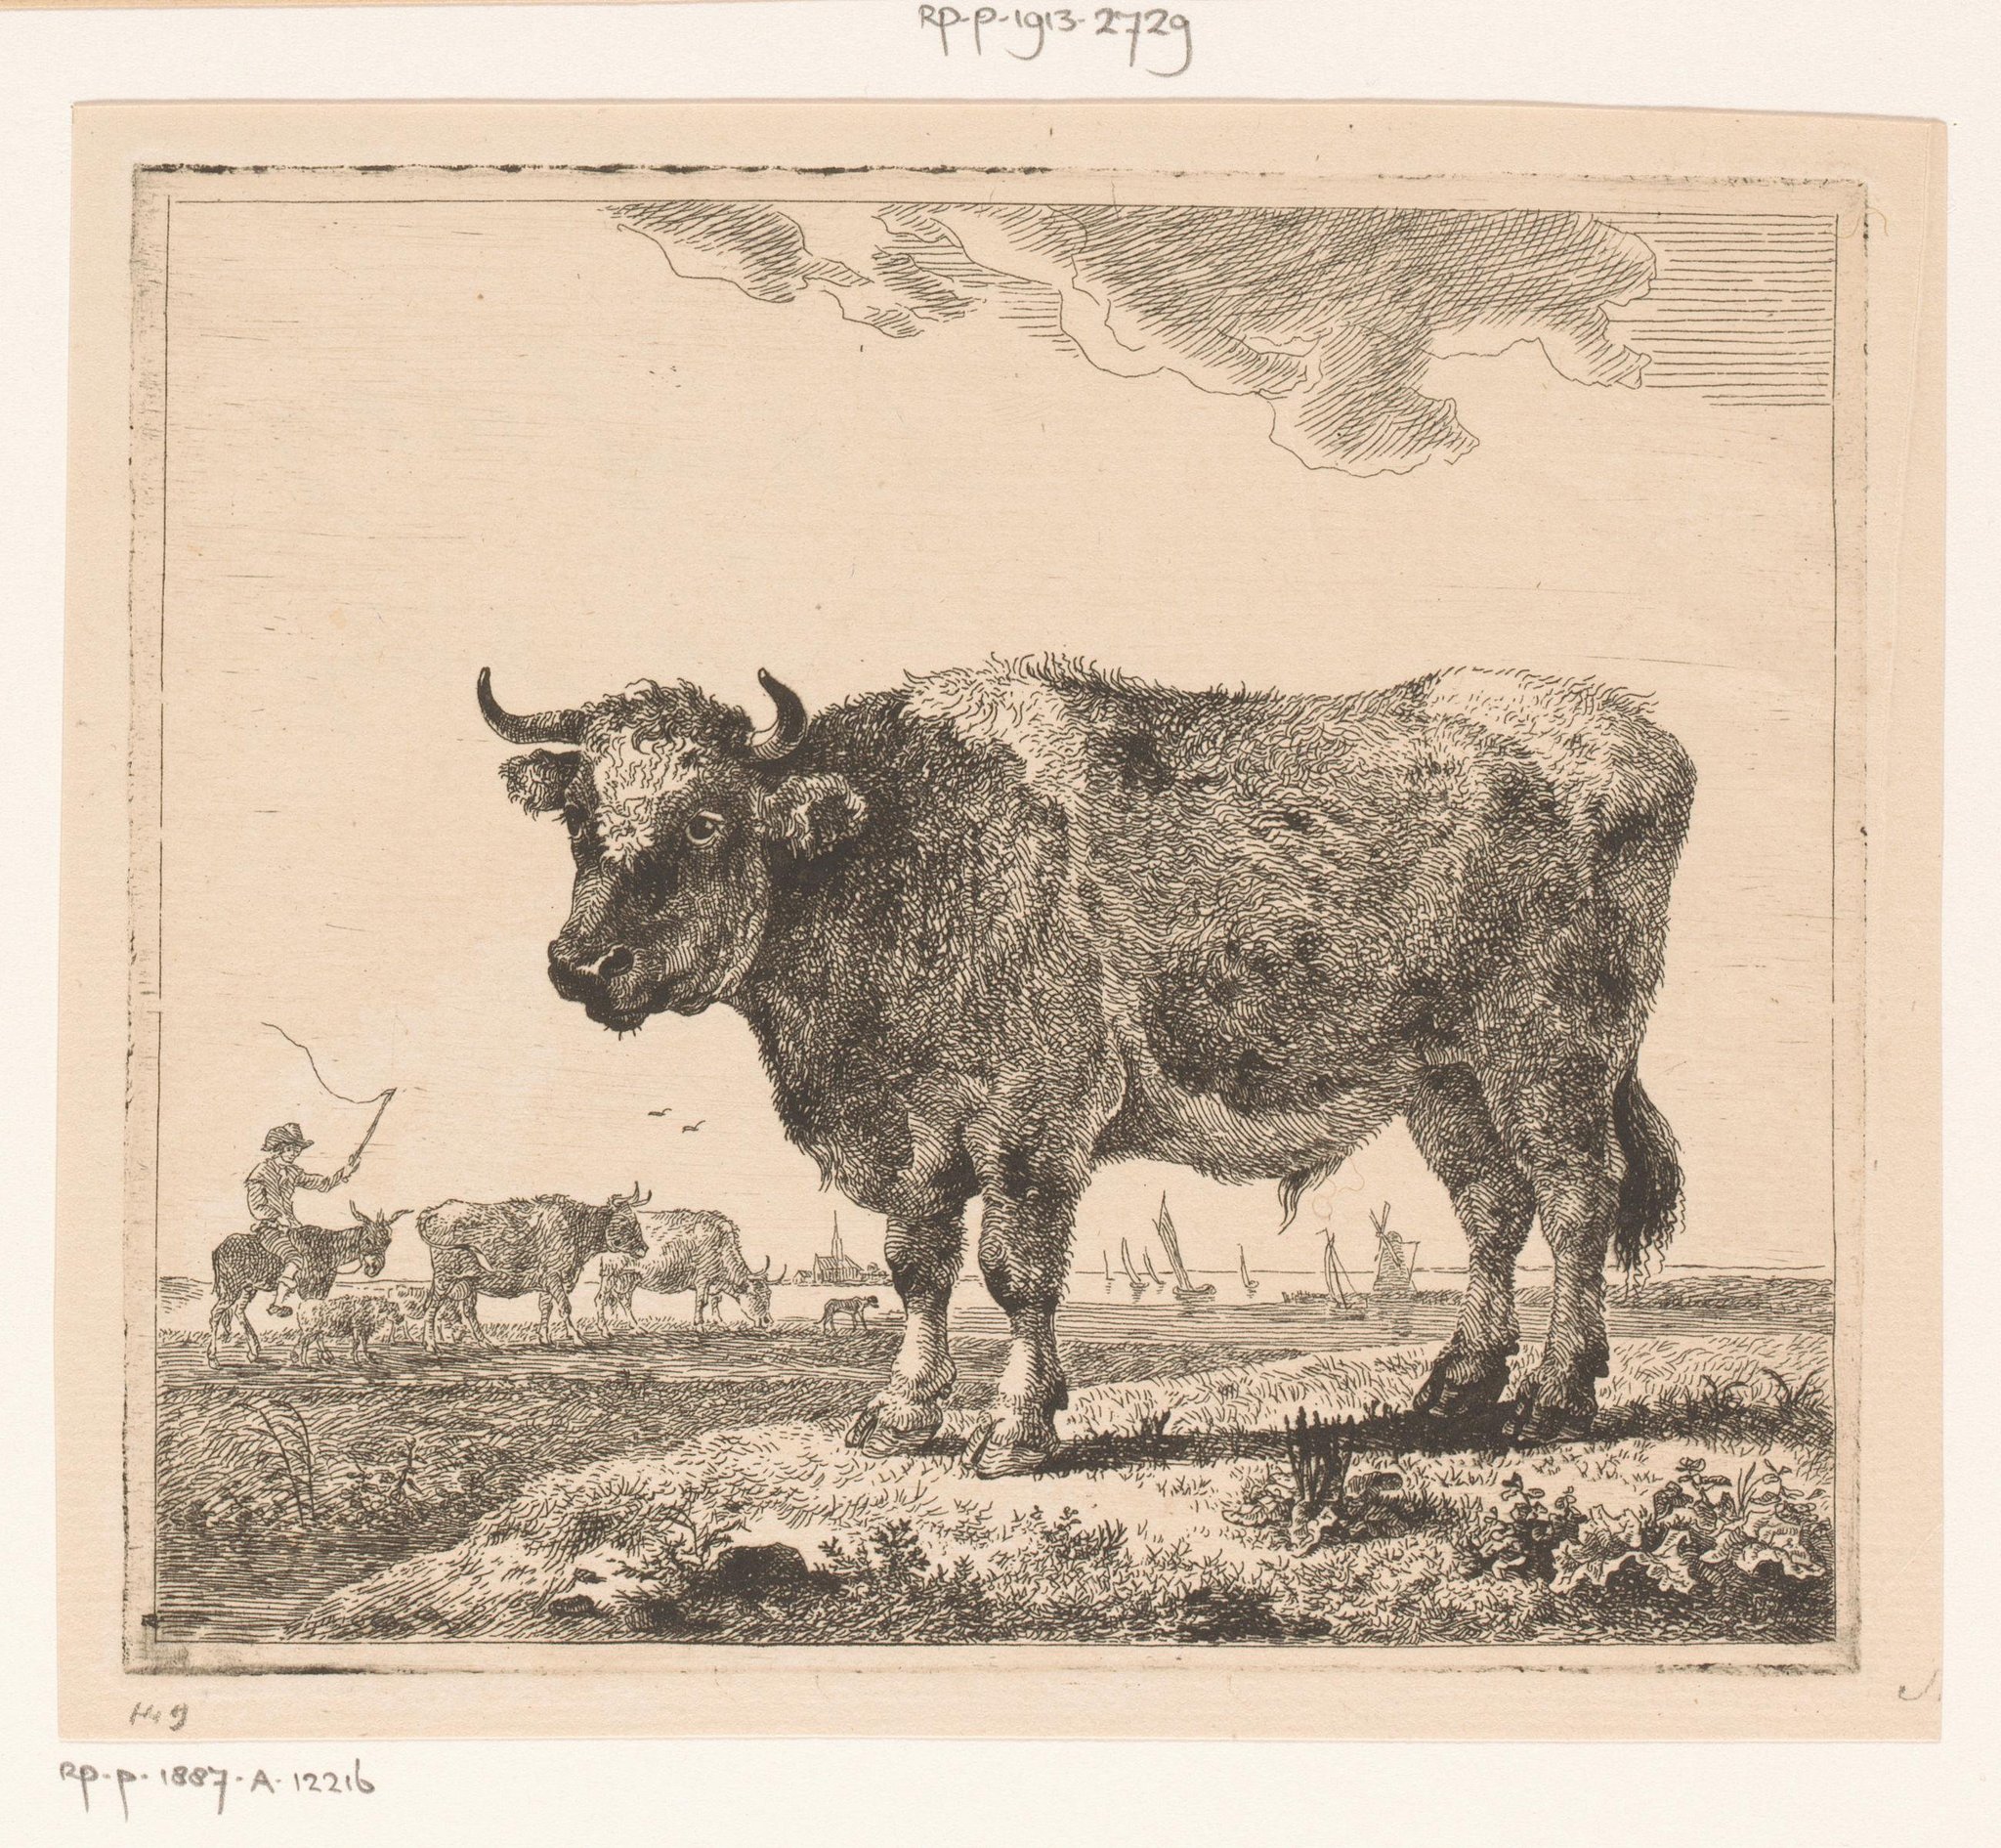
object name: print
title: Landschap met os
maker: jean baptiste de roy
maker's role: print maker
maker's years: 1759-1839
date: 1769-1839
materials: paper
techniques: etching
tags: cow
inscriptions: collector's mark: Lugt 2228